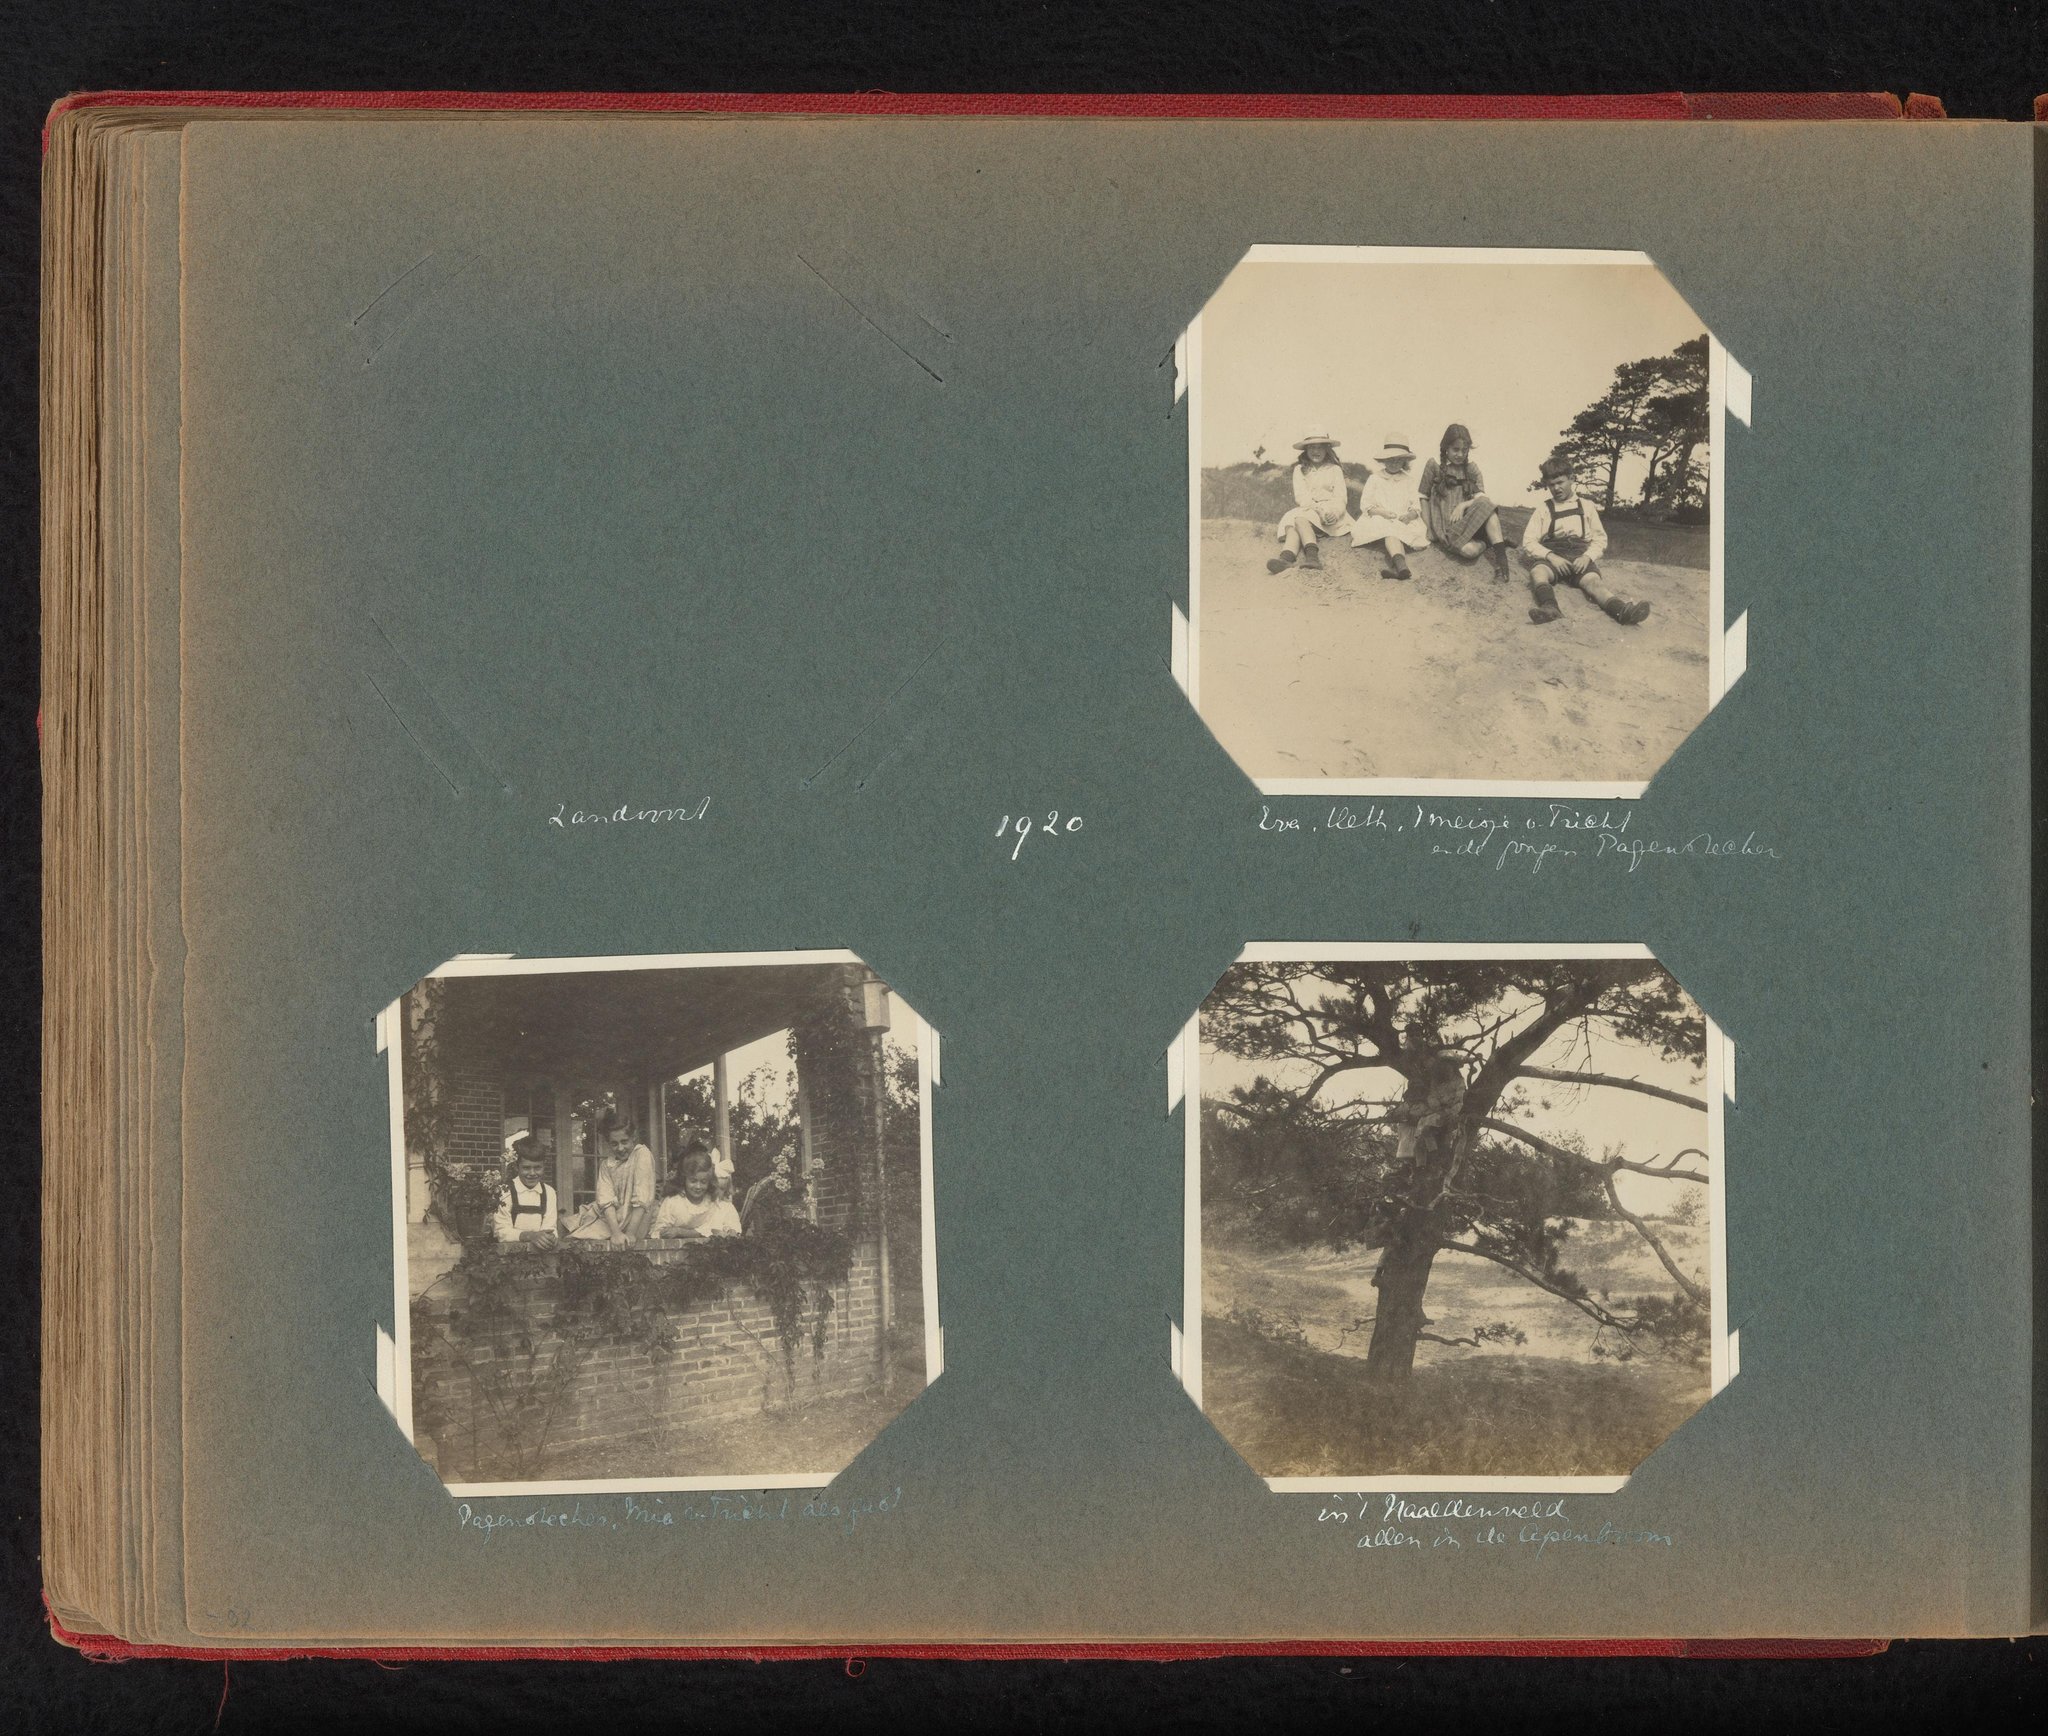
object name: album leaf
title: Eva en Hetty Boelen met de meisjes van Tricht en een jongen in het Naaldenveld in Aerdenhout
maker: charlotte alida boelen-matthes (lot)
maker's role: amateurfotograaf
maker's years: 1889-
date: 1920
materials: paper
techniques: gelatin silver print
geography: aerdenhout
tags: amsterdam, eva charlotte pennink-boelen, forest, wood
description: Deze foto's zijn onderdeel van een album.